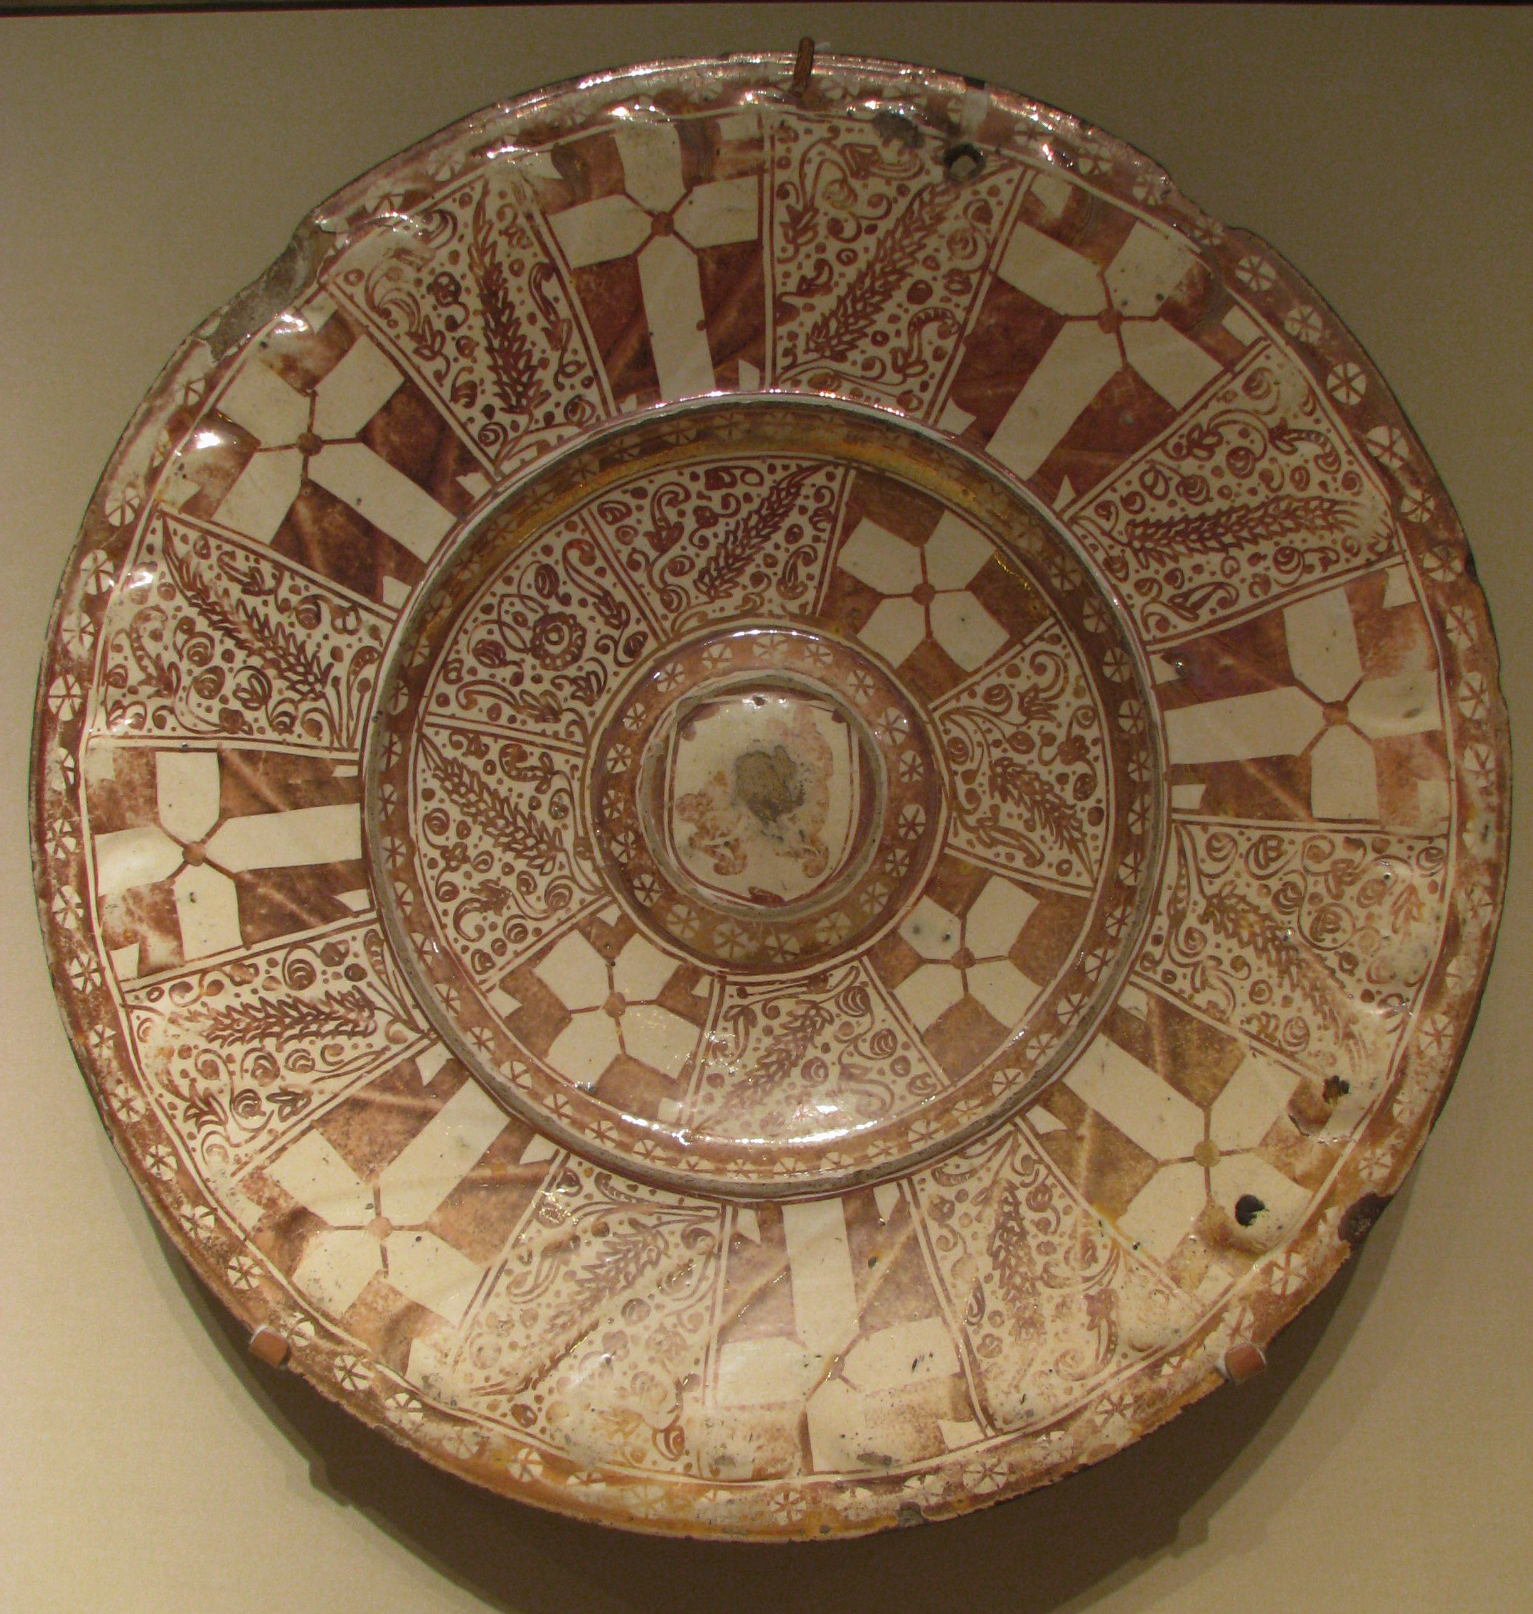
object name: plateau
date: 1501-1600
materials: earthenware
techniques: luster painting, glazing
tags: cross